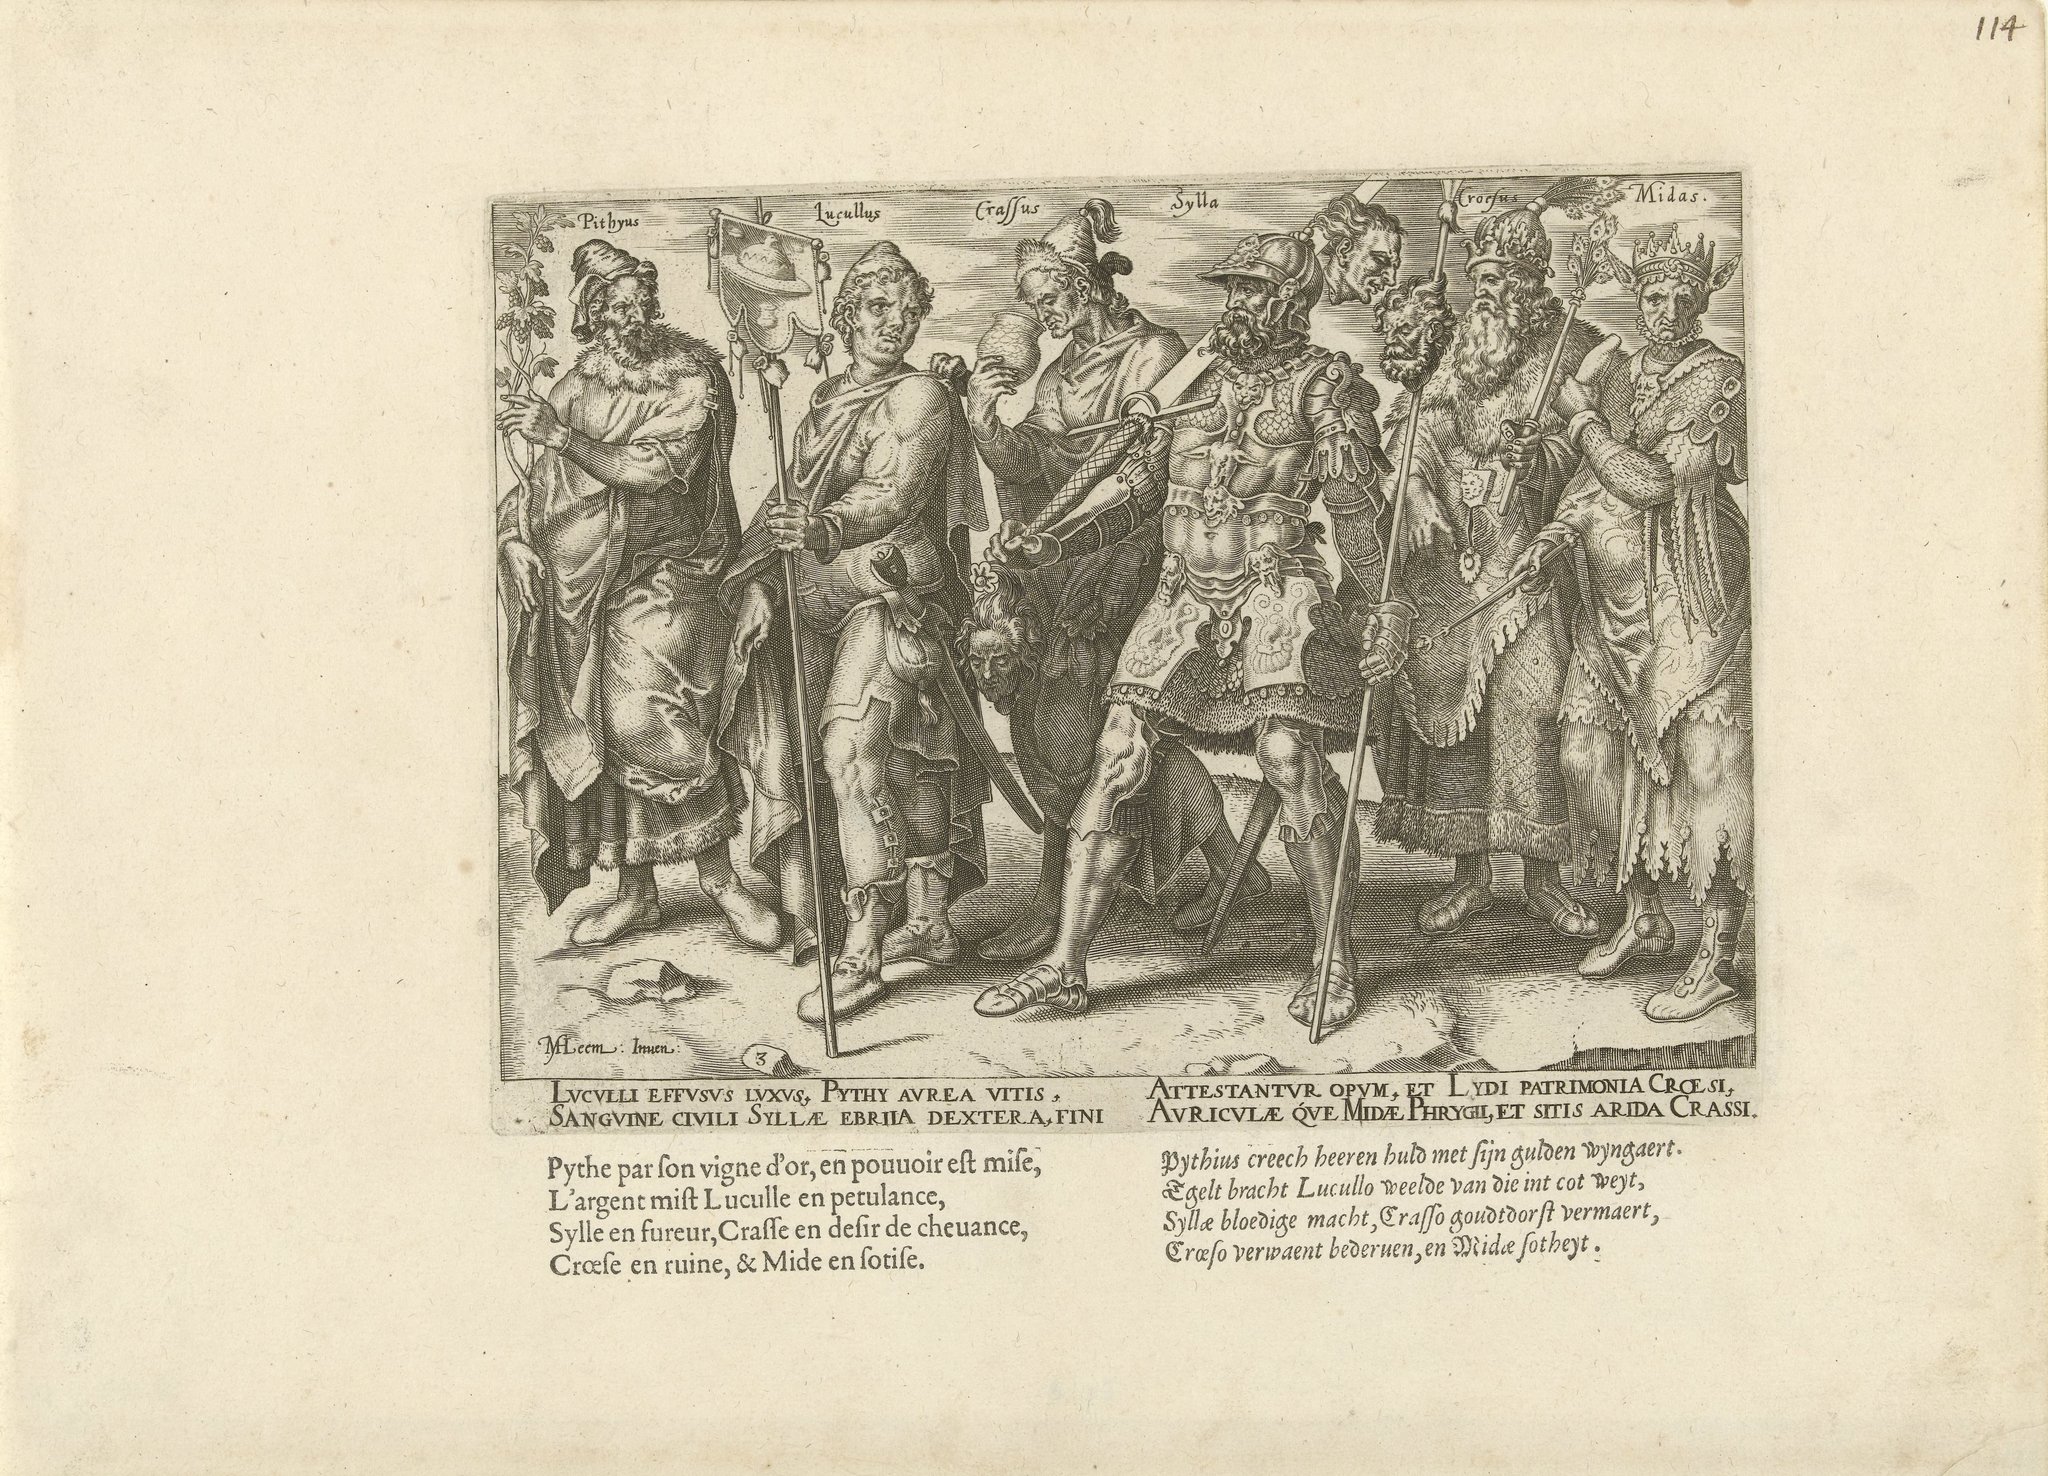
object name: print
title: Beroemde en beruchte rijkaards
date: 1563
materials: paper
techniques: engraving, letterpress printing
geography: antwerp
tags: contemplating one's own riches, (story of) m. licinius crassus, (story of) croesus king of lydia, (story of) midas, male persons from classical history (sulla), male persons from classical history (pythius), male persons from classical history (lucullus)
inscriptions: collector's mark: Lugt 2228, collector's mark: Lugt 2760, number: ‘114’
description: Een optocht van beroemde voorbeelden van rijkaards uit de Oudheid. Voorop in de stoet Pythius, met in zijn hand een van goud en edelstenen gemaakte wijnrank. Vervolgens Lucullus, de rijke Romeinse magistraat en veelvraat. Hij draagt een vaandel met een kippenpastei. Achter hem Crassus, die uit een beker drinkt. Dit is een allusie op zijn dorst naar geld en zijn dood (gestikt in gesmolten goud). Na Crassus komen de dictator Sulla met een zwaard en een lans, Croesus als rijkgeklede koning en Midas met Midasoren onder zijn kroon. De prent heeft een Latijns onderschrift en een Nederlands en Frans onderschrift in boekdruk. De prent is deel van een serie met als onderwerp de ellende die rijkdom brengt.